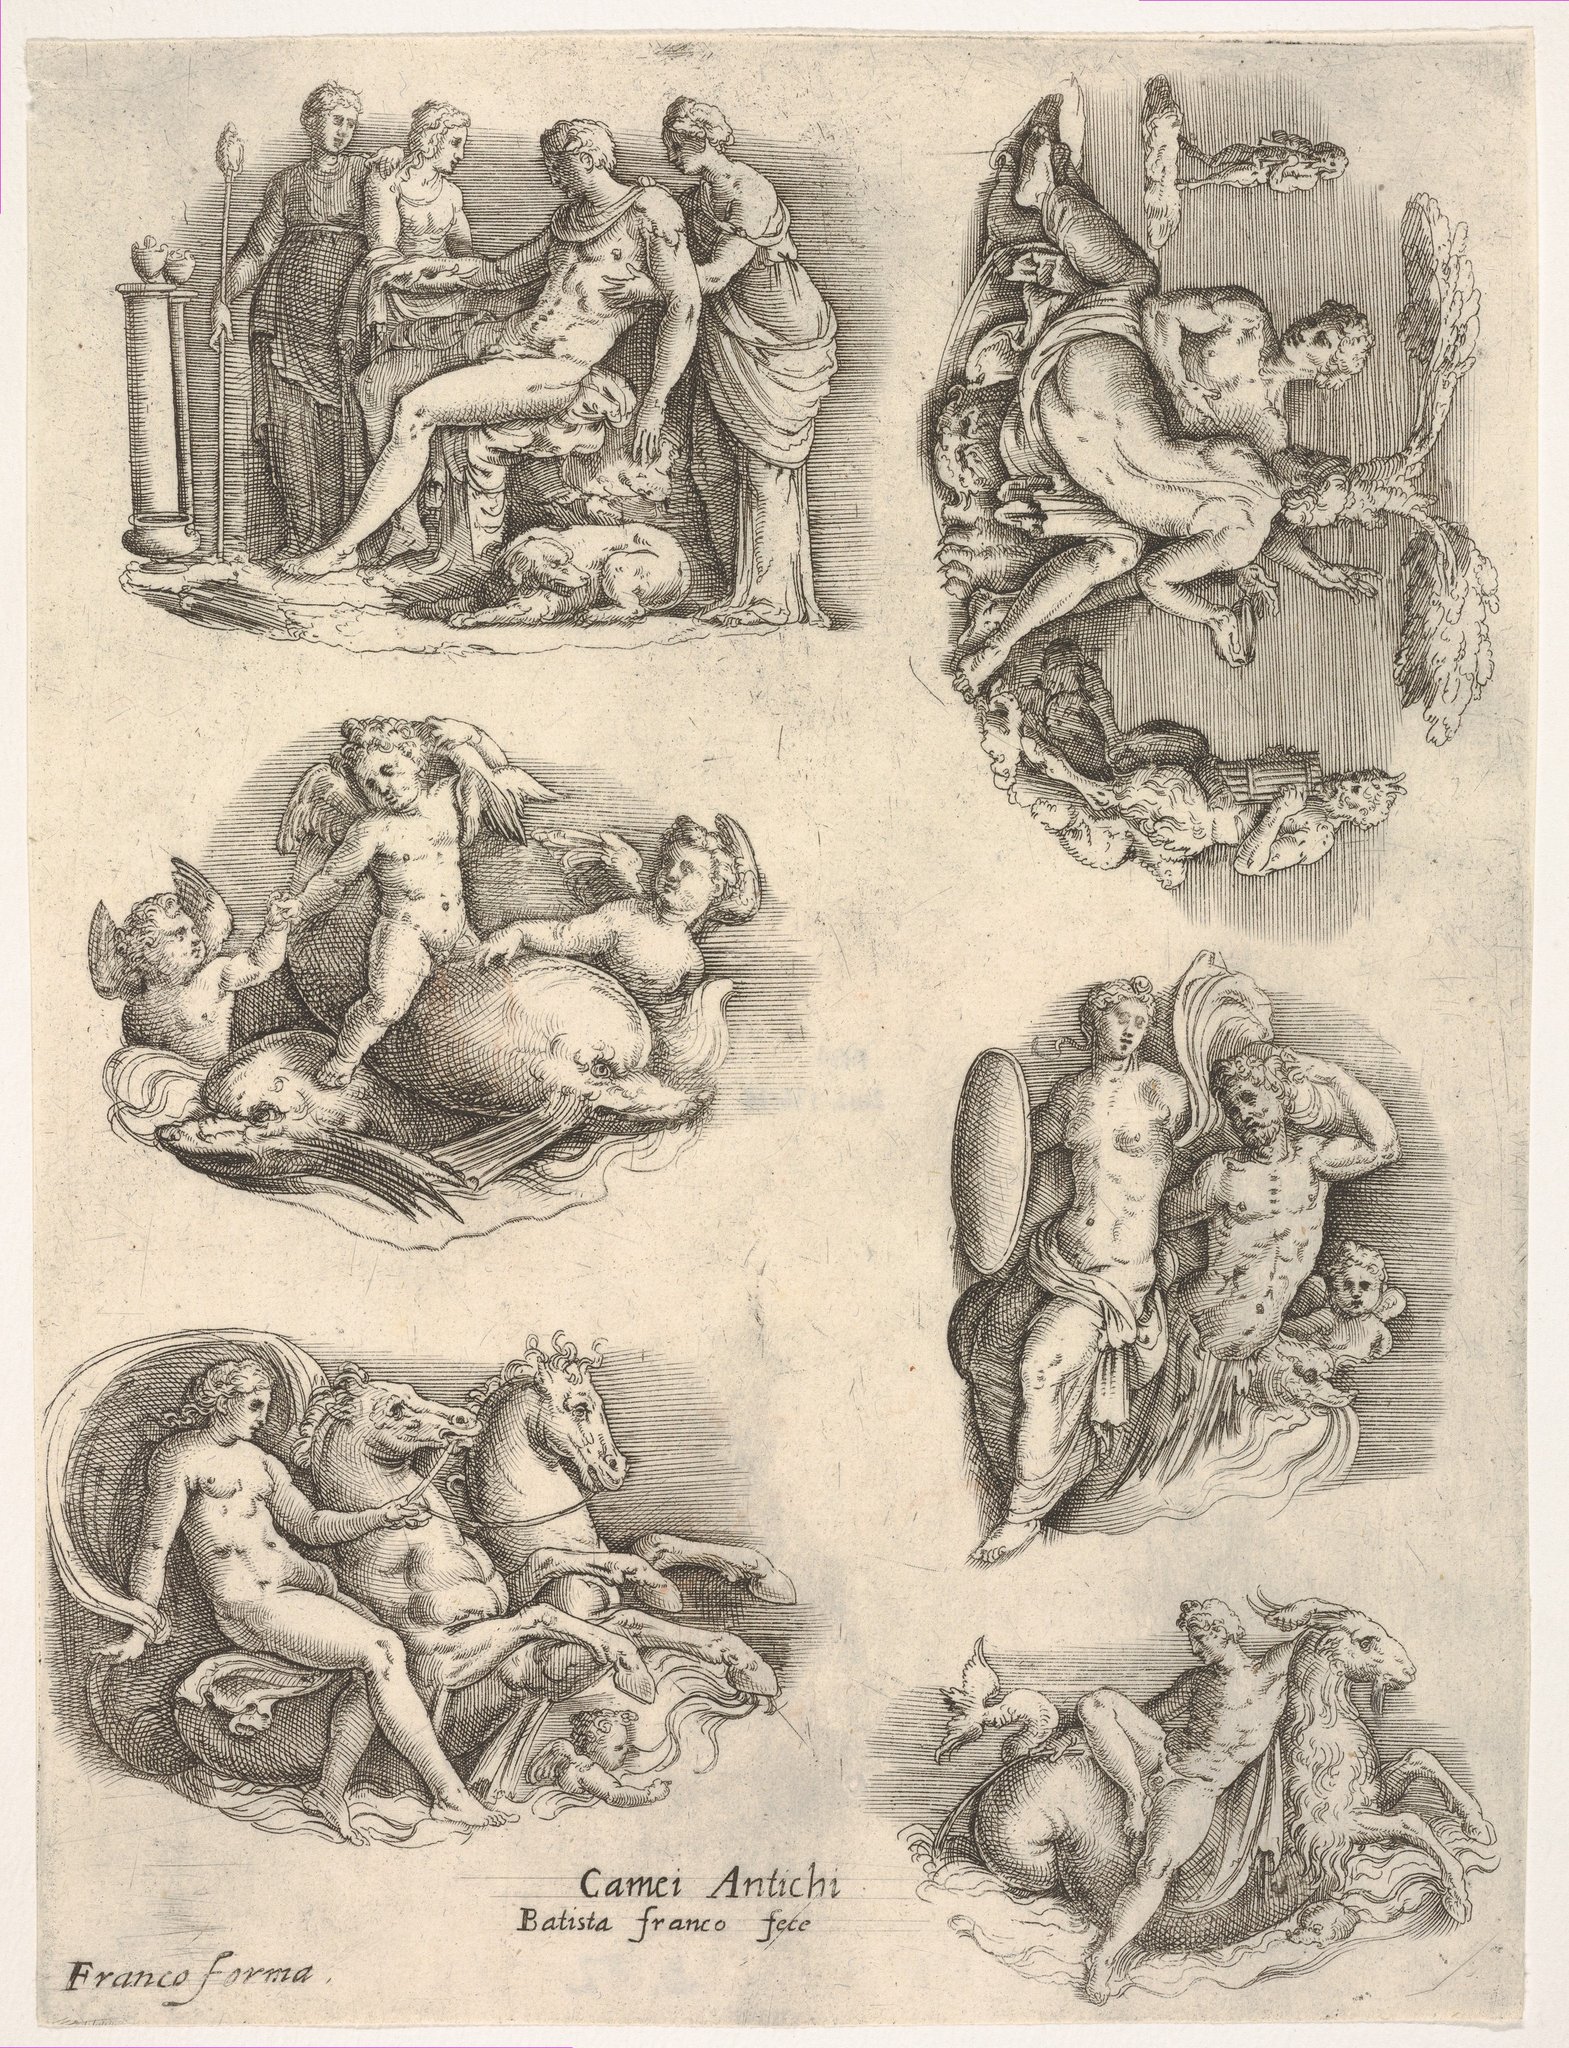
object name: print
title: Six subjects after antique cameos: female figures tending to a seated male figure; putti and dolphins; female figure holding the reins of a pair of rearing horses; intertwined naked figures flanked by music-playing satyrs; triton with shield-bearing female figure; naked male figure seated on goat-headed sea creature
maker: battista franco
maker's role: artist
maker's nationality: italian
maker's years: 1510-1561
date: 1510-1561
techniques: etching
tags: men,male nudes,women,female nudes,mythical creatures,dolphins,horses